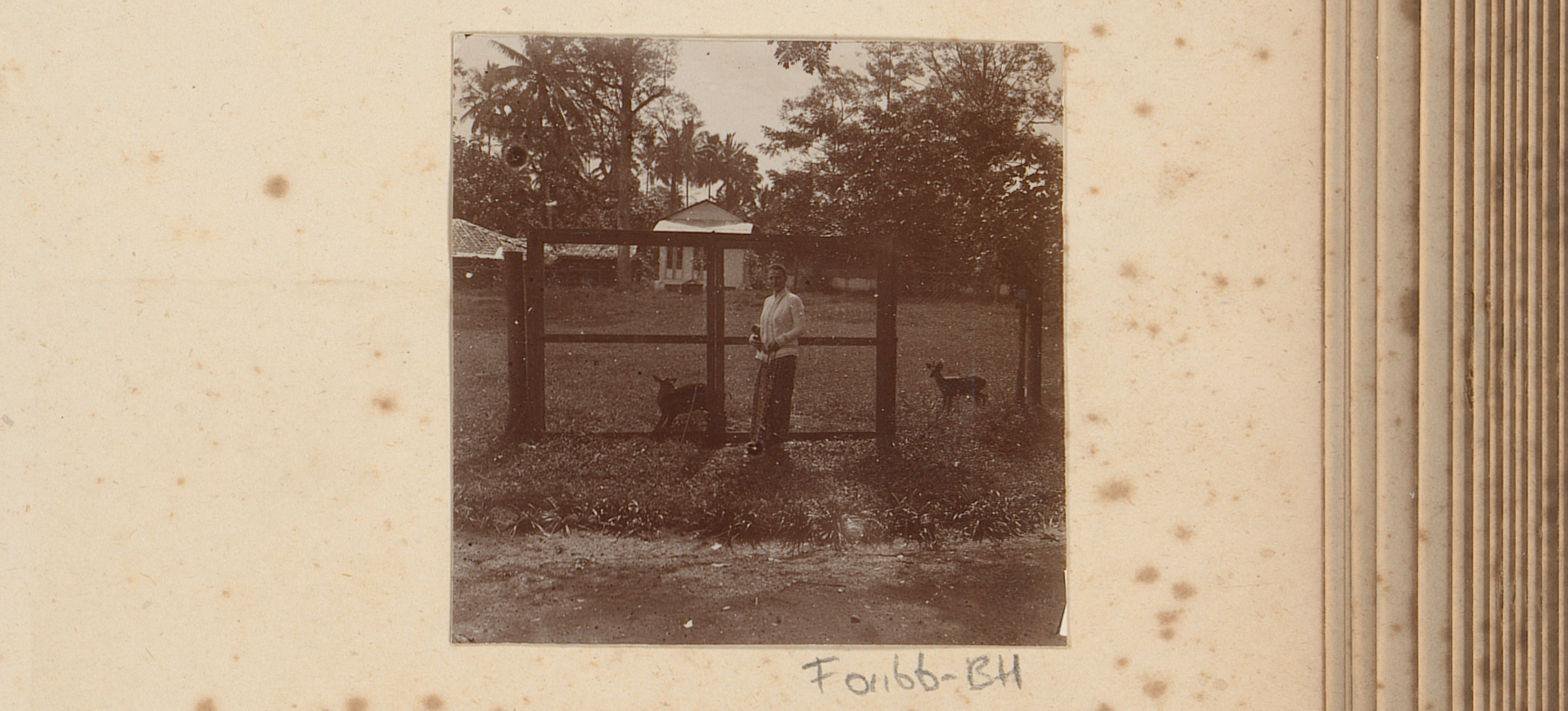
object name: album leaf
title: Nederlandse vrouw bij een hertenkamp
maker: Anonymous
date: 1895-1910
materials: photographic support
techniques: gelatin silver print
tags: adult woman, hoofed animals: deer, historical persons, dutch east indies, the